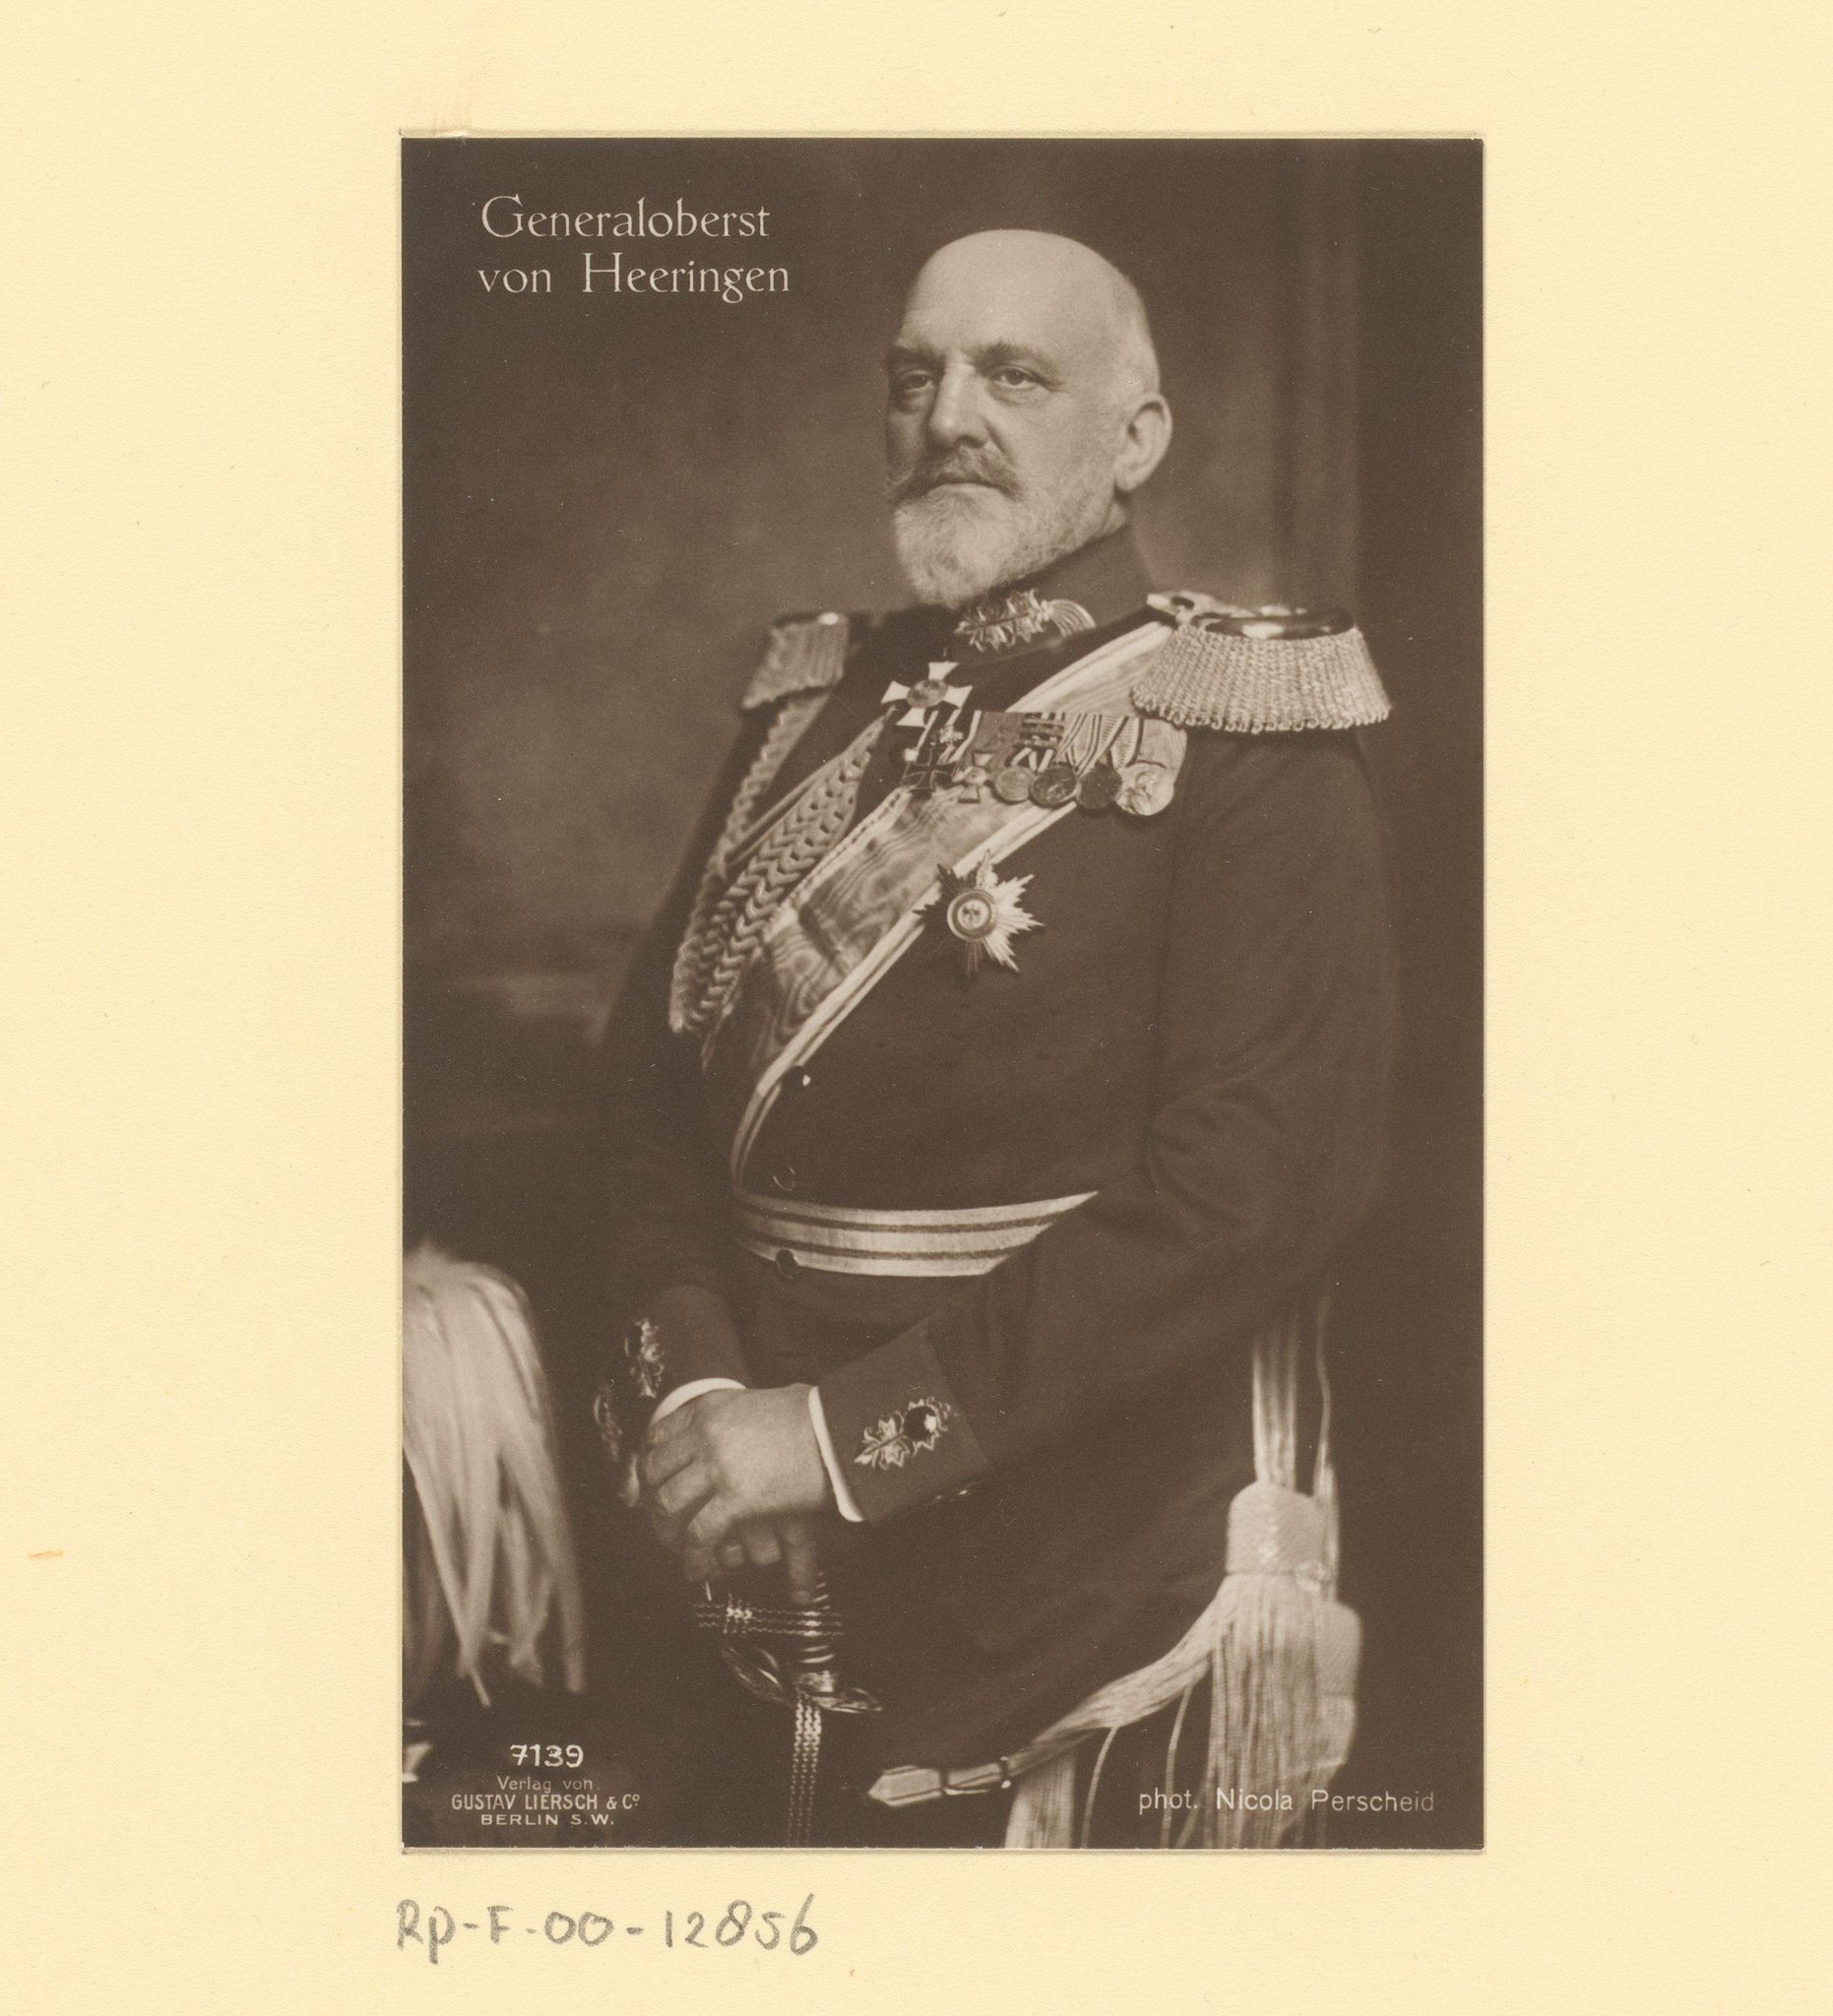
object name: photograph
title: Generaloberst von Heeringen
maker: nicola perscheid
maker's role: fotograaf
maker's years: 1864-1930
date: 1905-1910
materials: paper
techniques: gelatin silver print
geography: berlin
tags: portrait of opera-singer